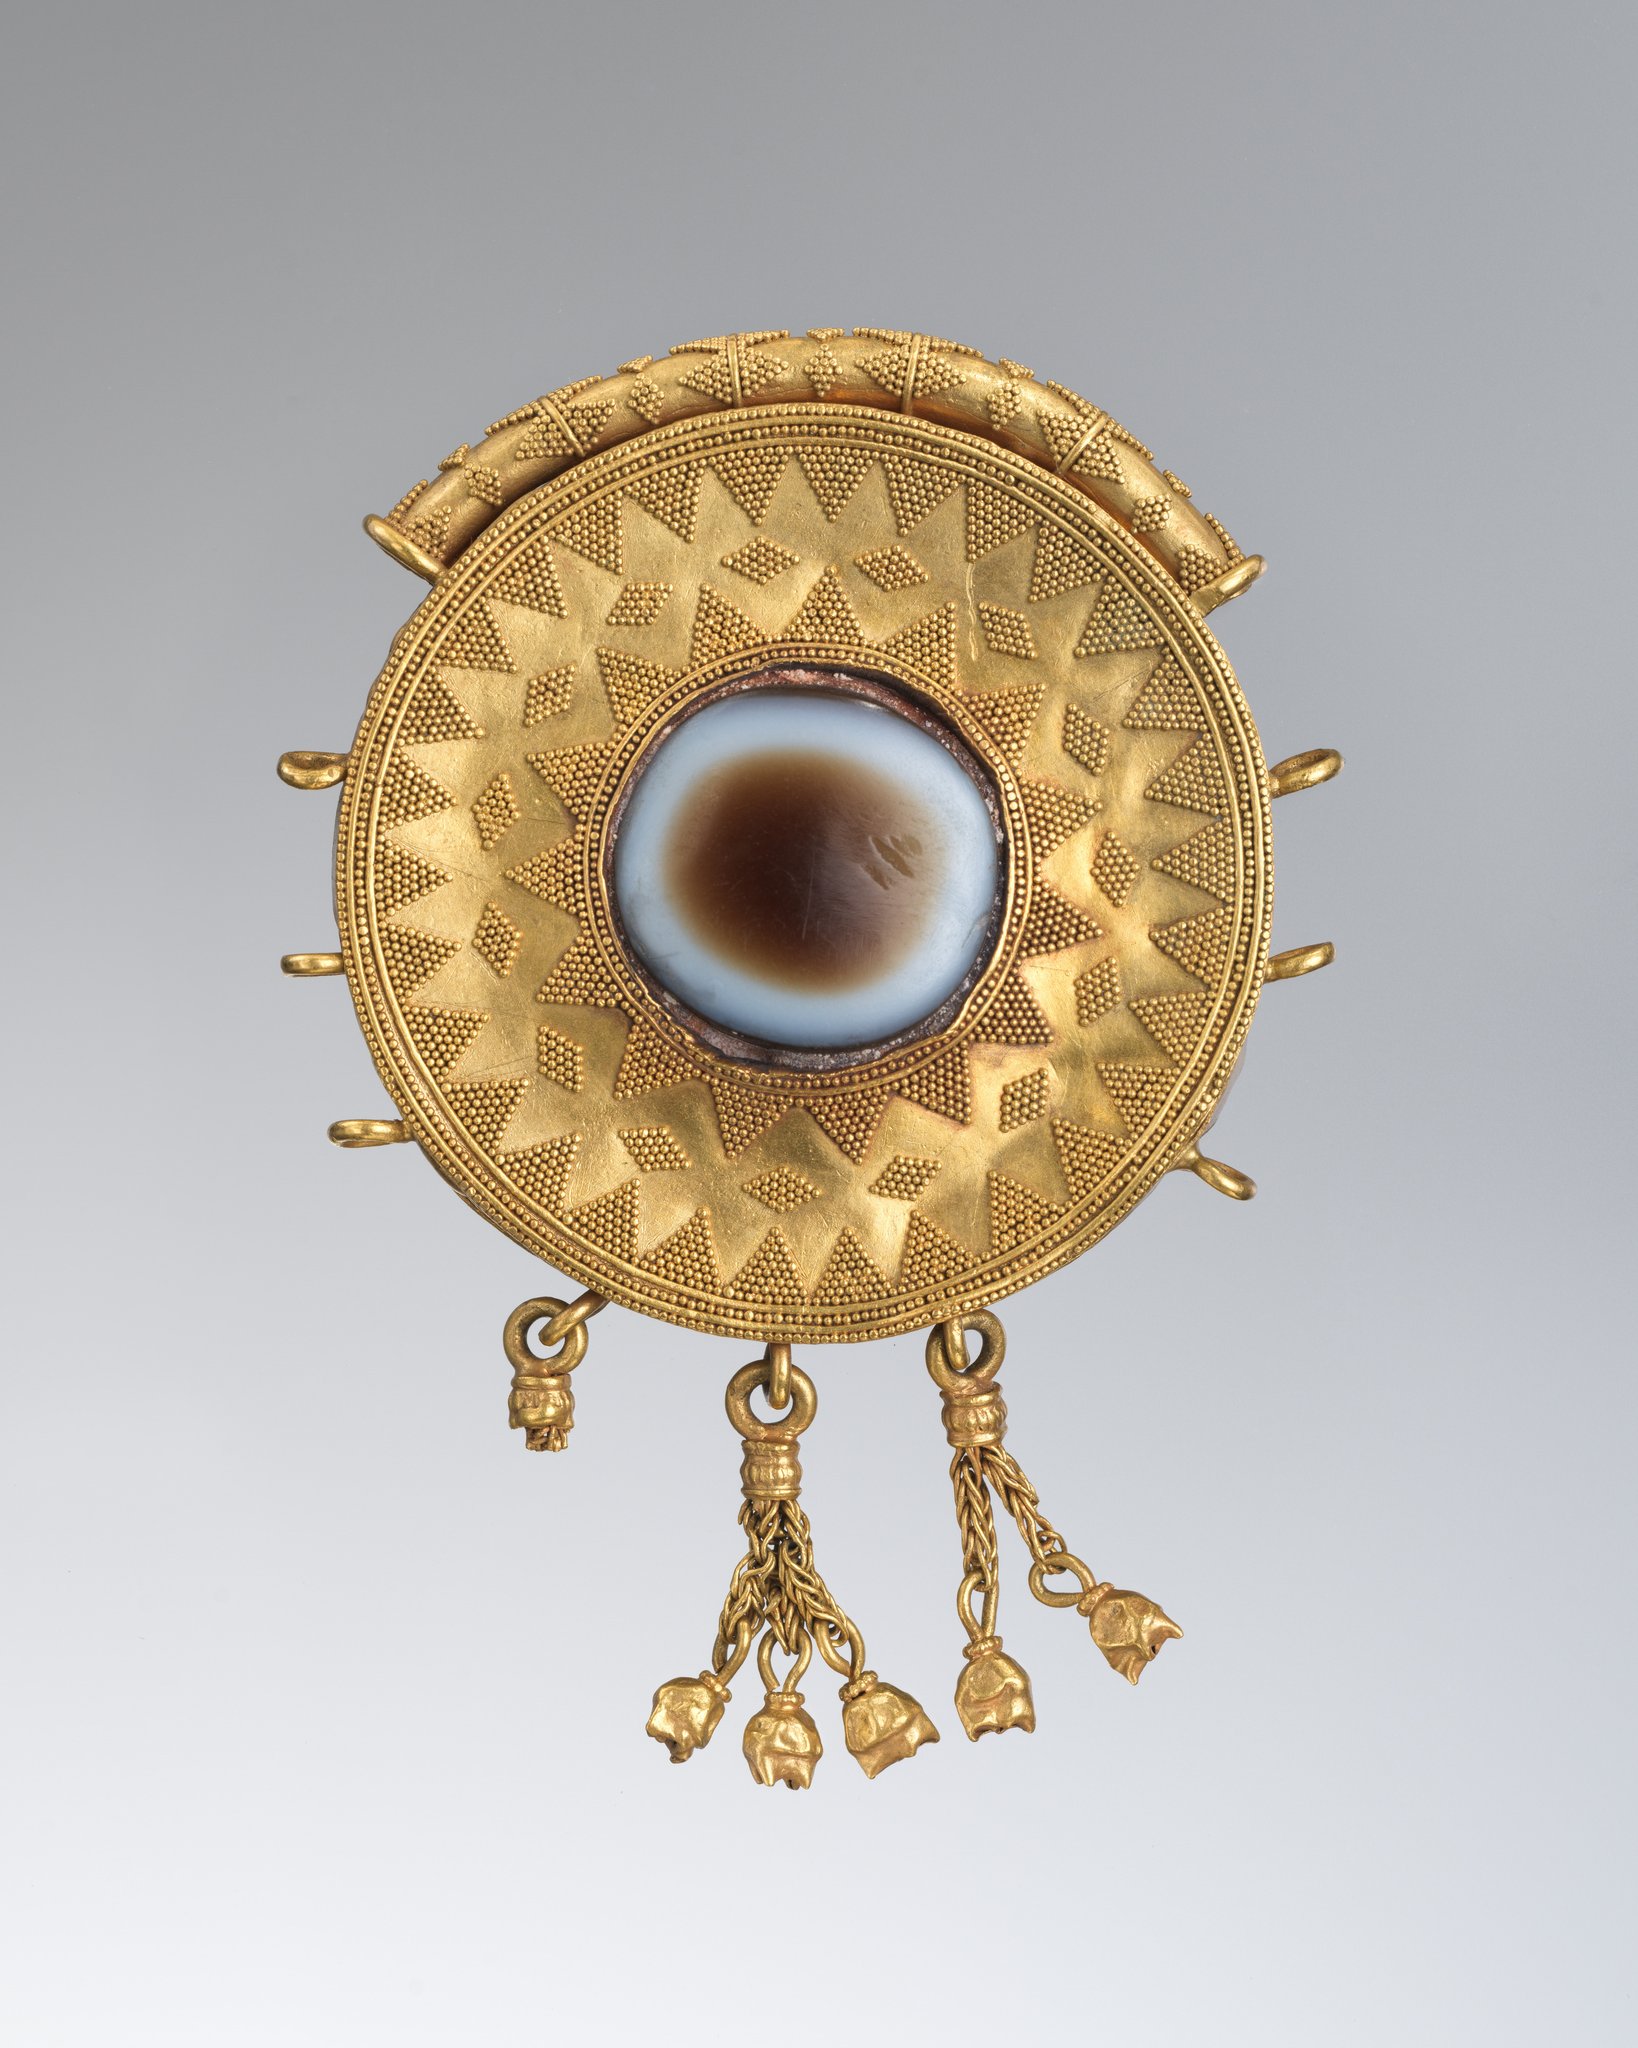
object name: pendant disc with bell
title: Pendant disc with bells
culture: cypriot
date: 3900 BCE-100 CE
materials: gold